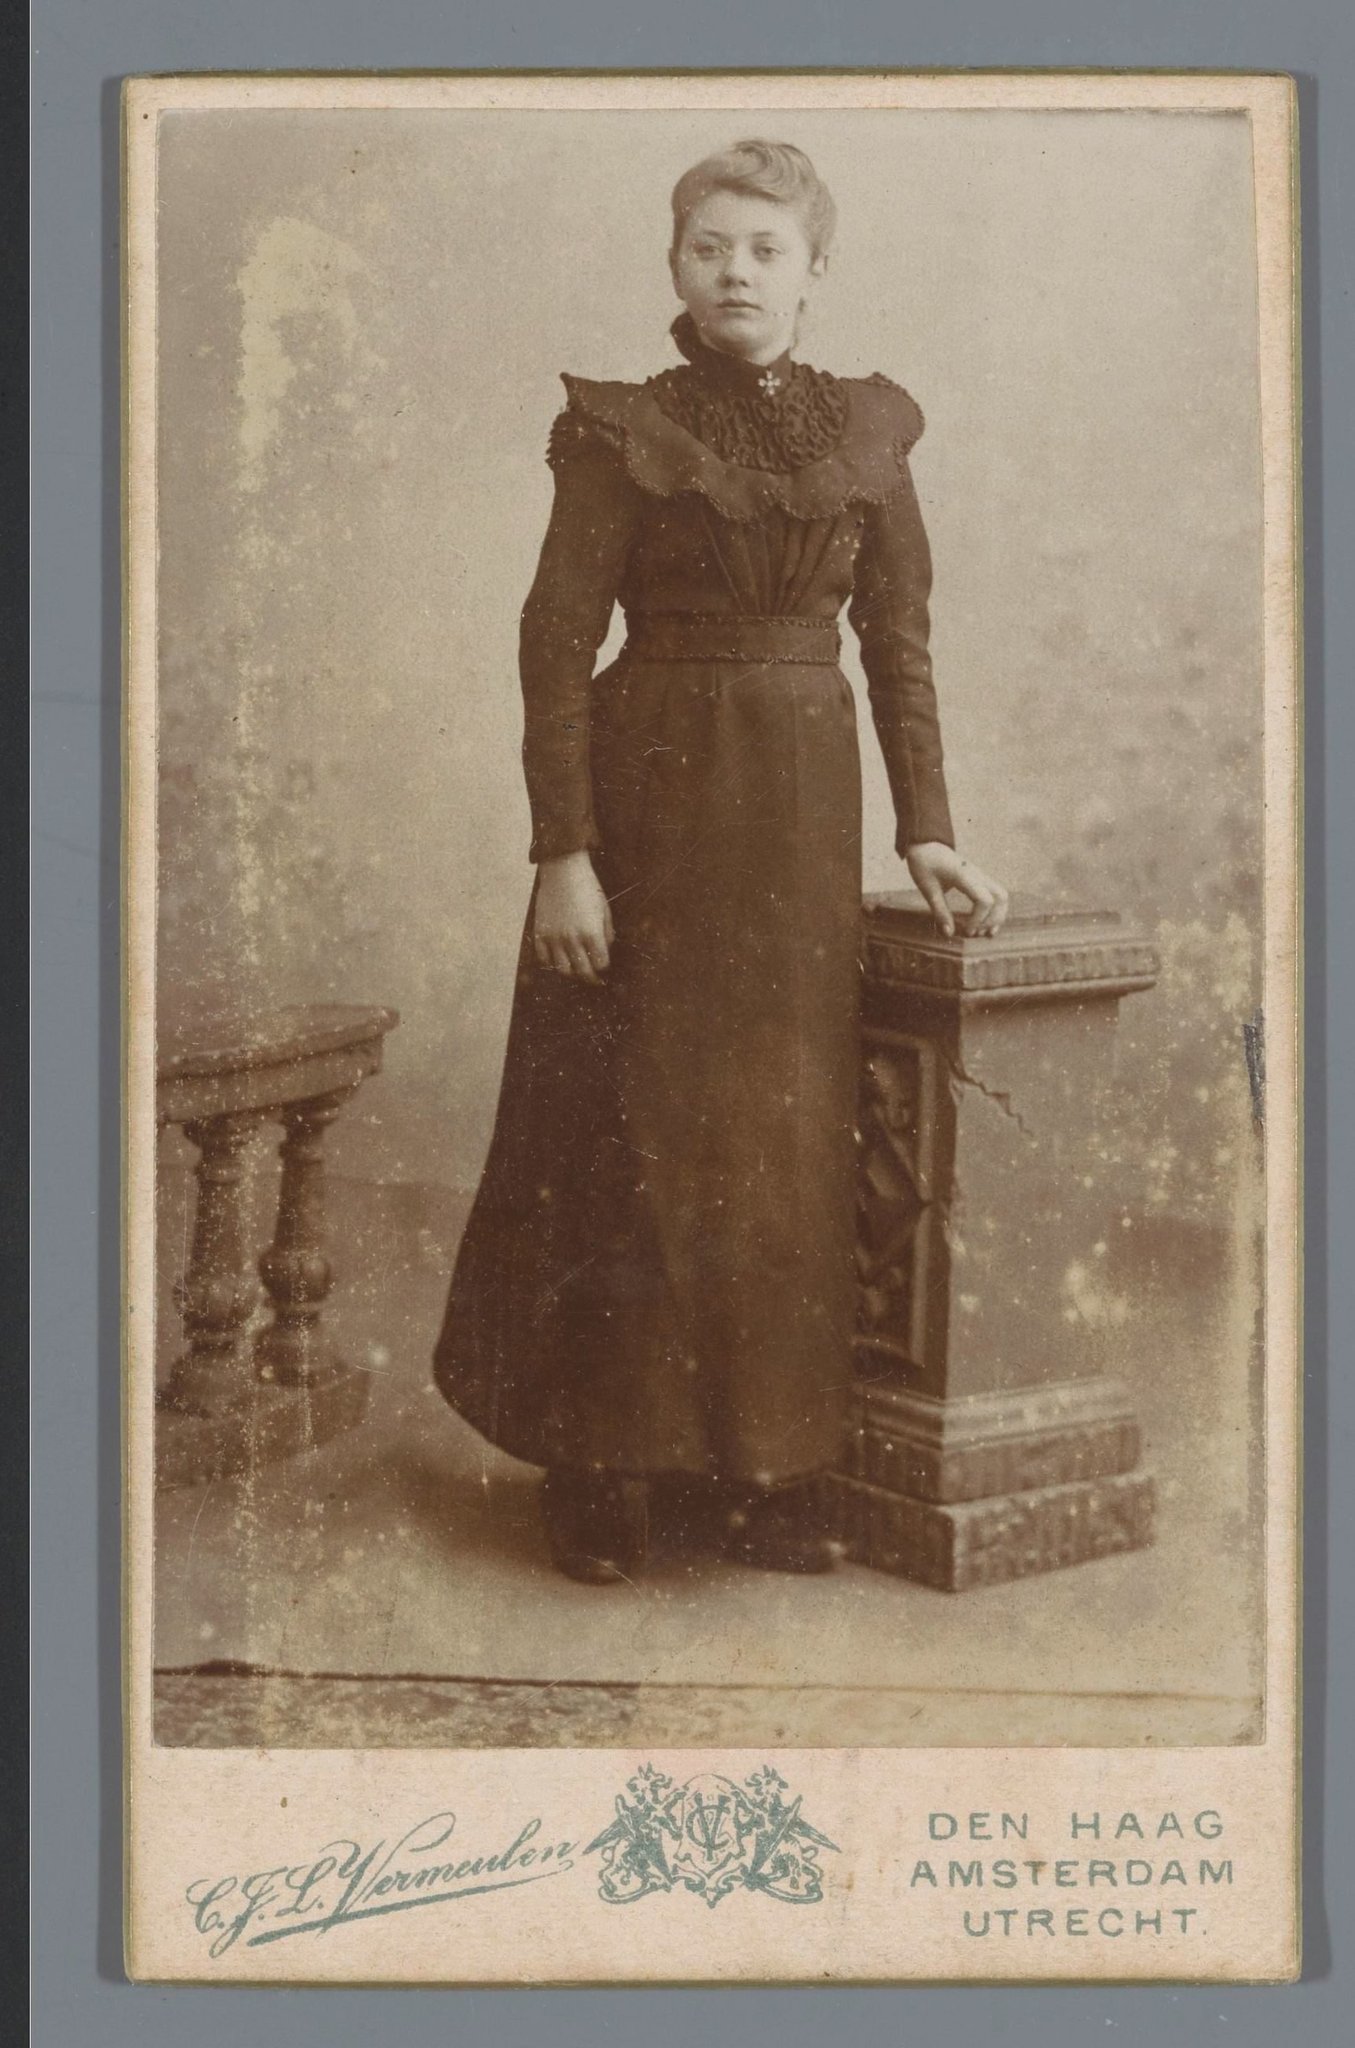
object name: carte de visite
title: Portret van een onbekende vrouw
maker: cornelis johannes lodewicus vermeulen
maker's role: fotograaf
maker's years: 1861-1936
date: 1890-1915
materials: cardboard, photographic support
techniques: collodion silver print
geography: the hague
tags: historical persons - bb - woman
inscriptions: inscription: ‘CV/ C. J. L. Vermeulen/ DEN HAAG/ Toussaintkade 11./ Intercommunal Telephoon: 774./ AMSTERDAM/ Heiligenweg hoek Singel./ Telephoon No 2340./ UTRECHT/ Nieuwe gracht 50./ Telephoon No 750./ BLOCK & Co. BERLIN S.W.’